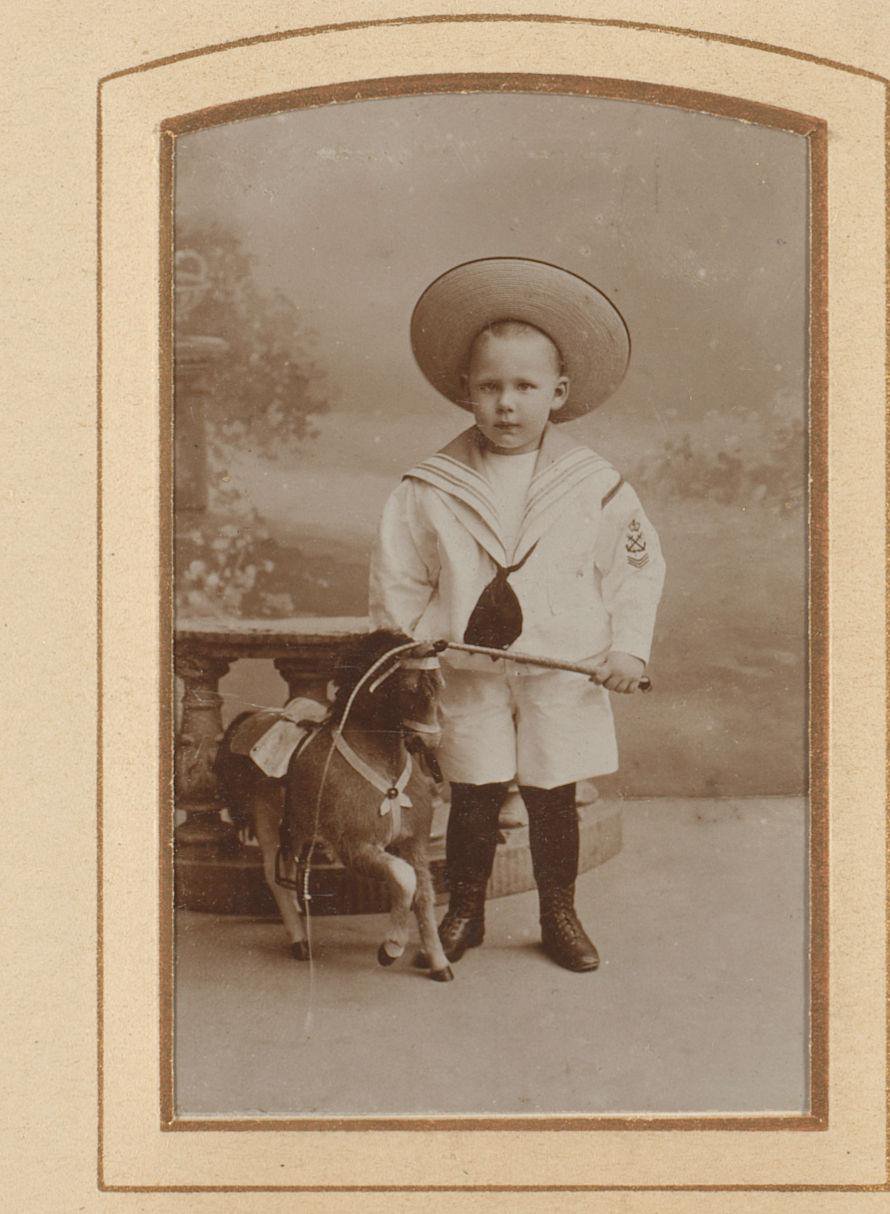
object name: photograph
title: Portret van een jongen met speelgoedpaard en hoed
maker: Anonymous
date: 1890-1920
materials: cardboard, photographic support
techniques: collodion silver print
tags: boy (child between toddler and youth), head-gear: hat, (playing with) dolls, toy animals